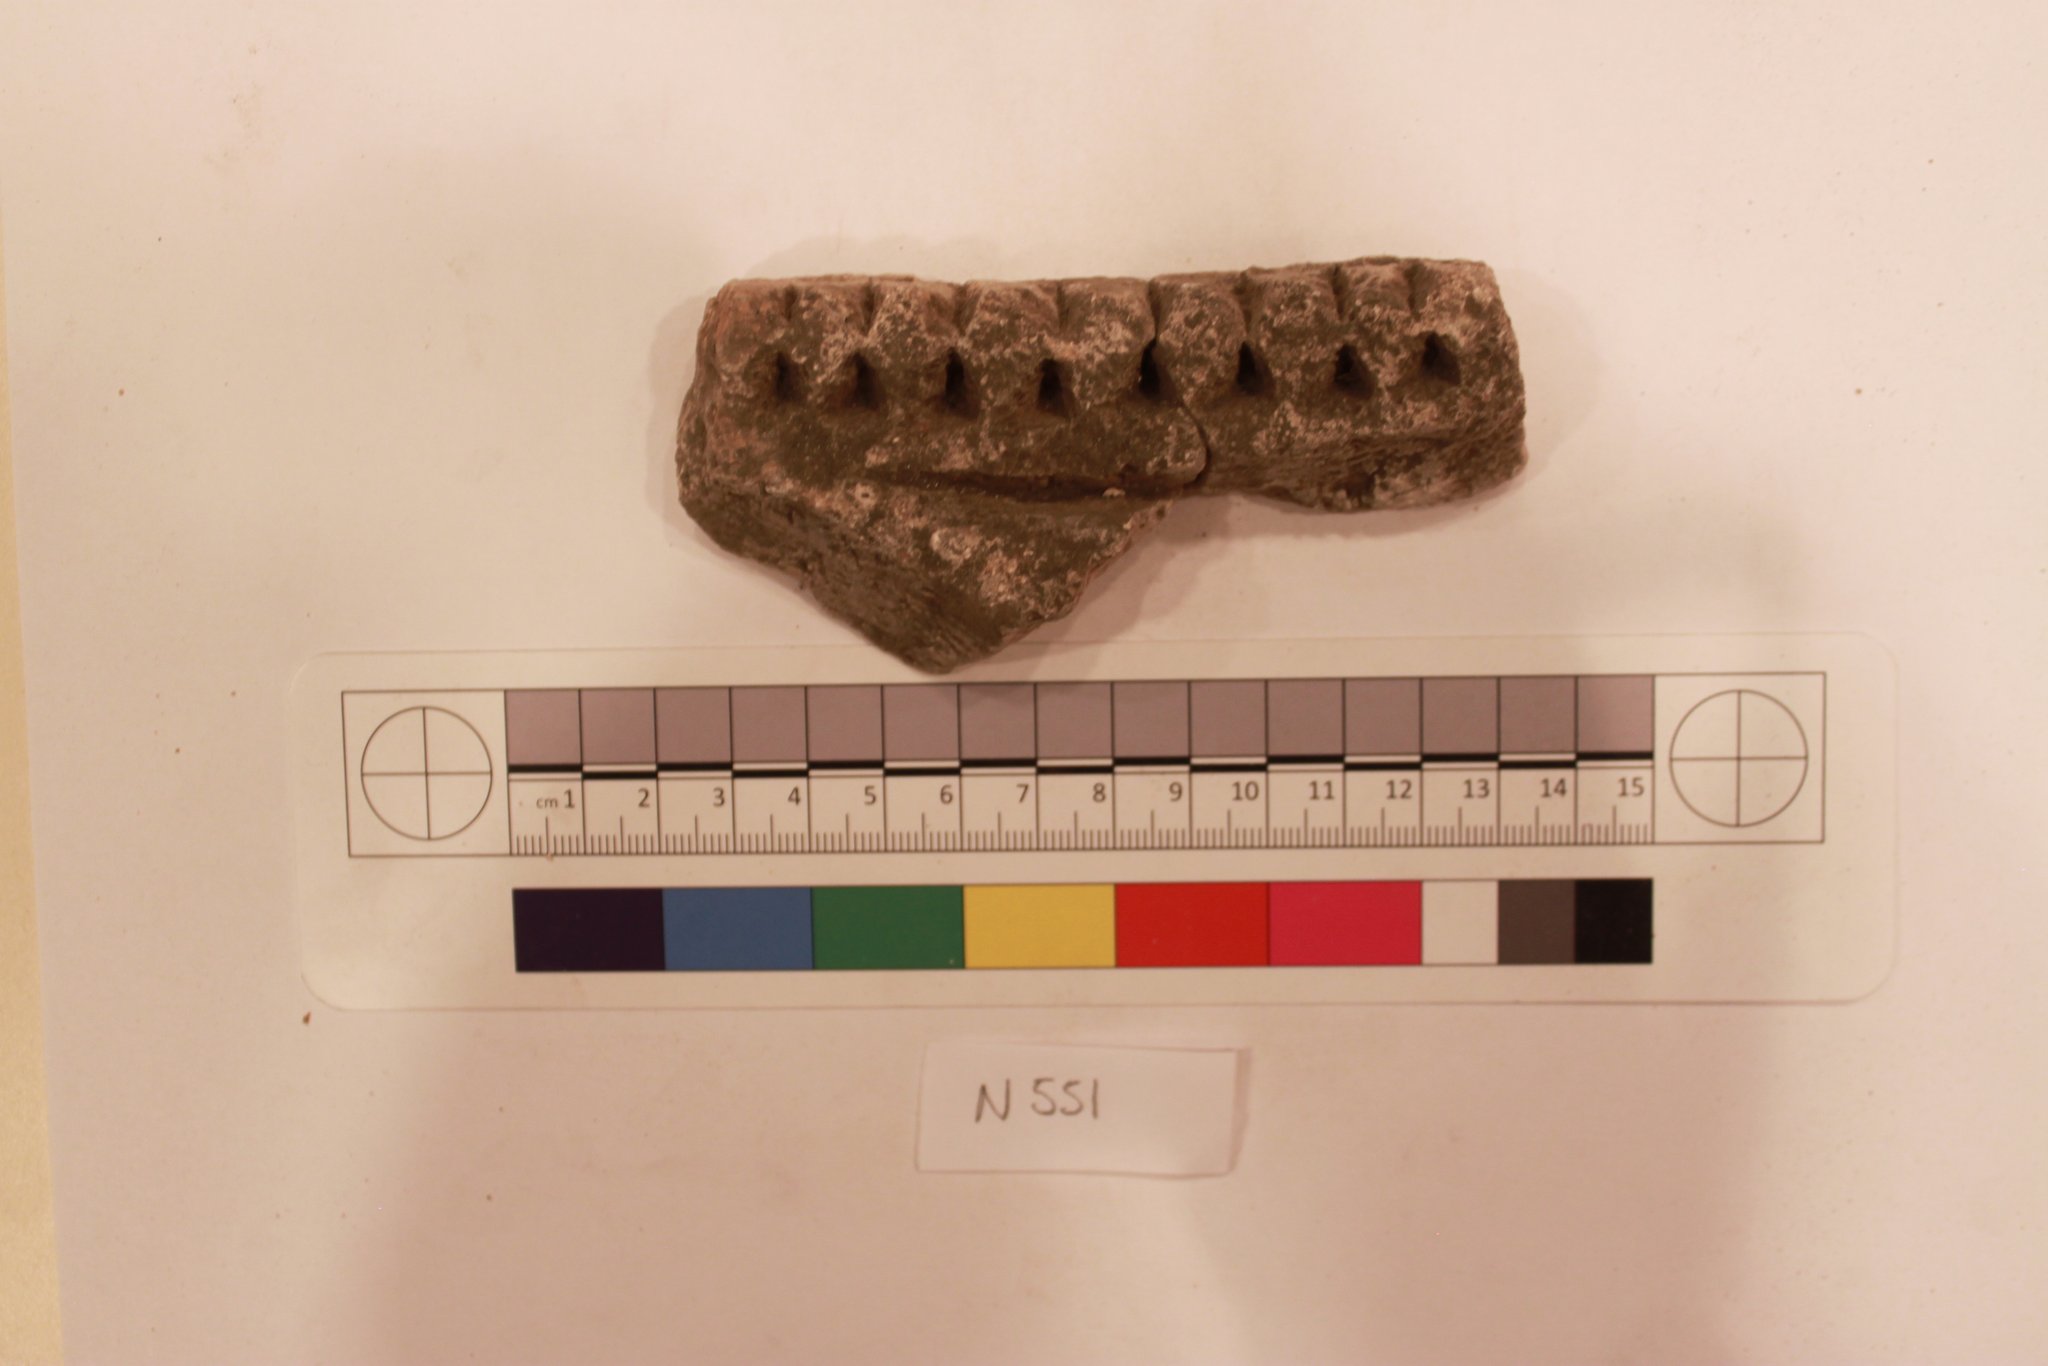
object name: fragment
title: Stucco Fragment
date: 701-1200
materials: plaster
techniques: carving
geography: iran